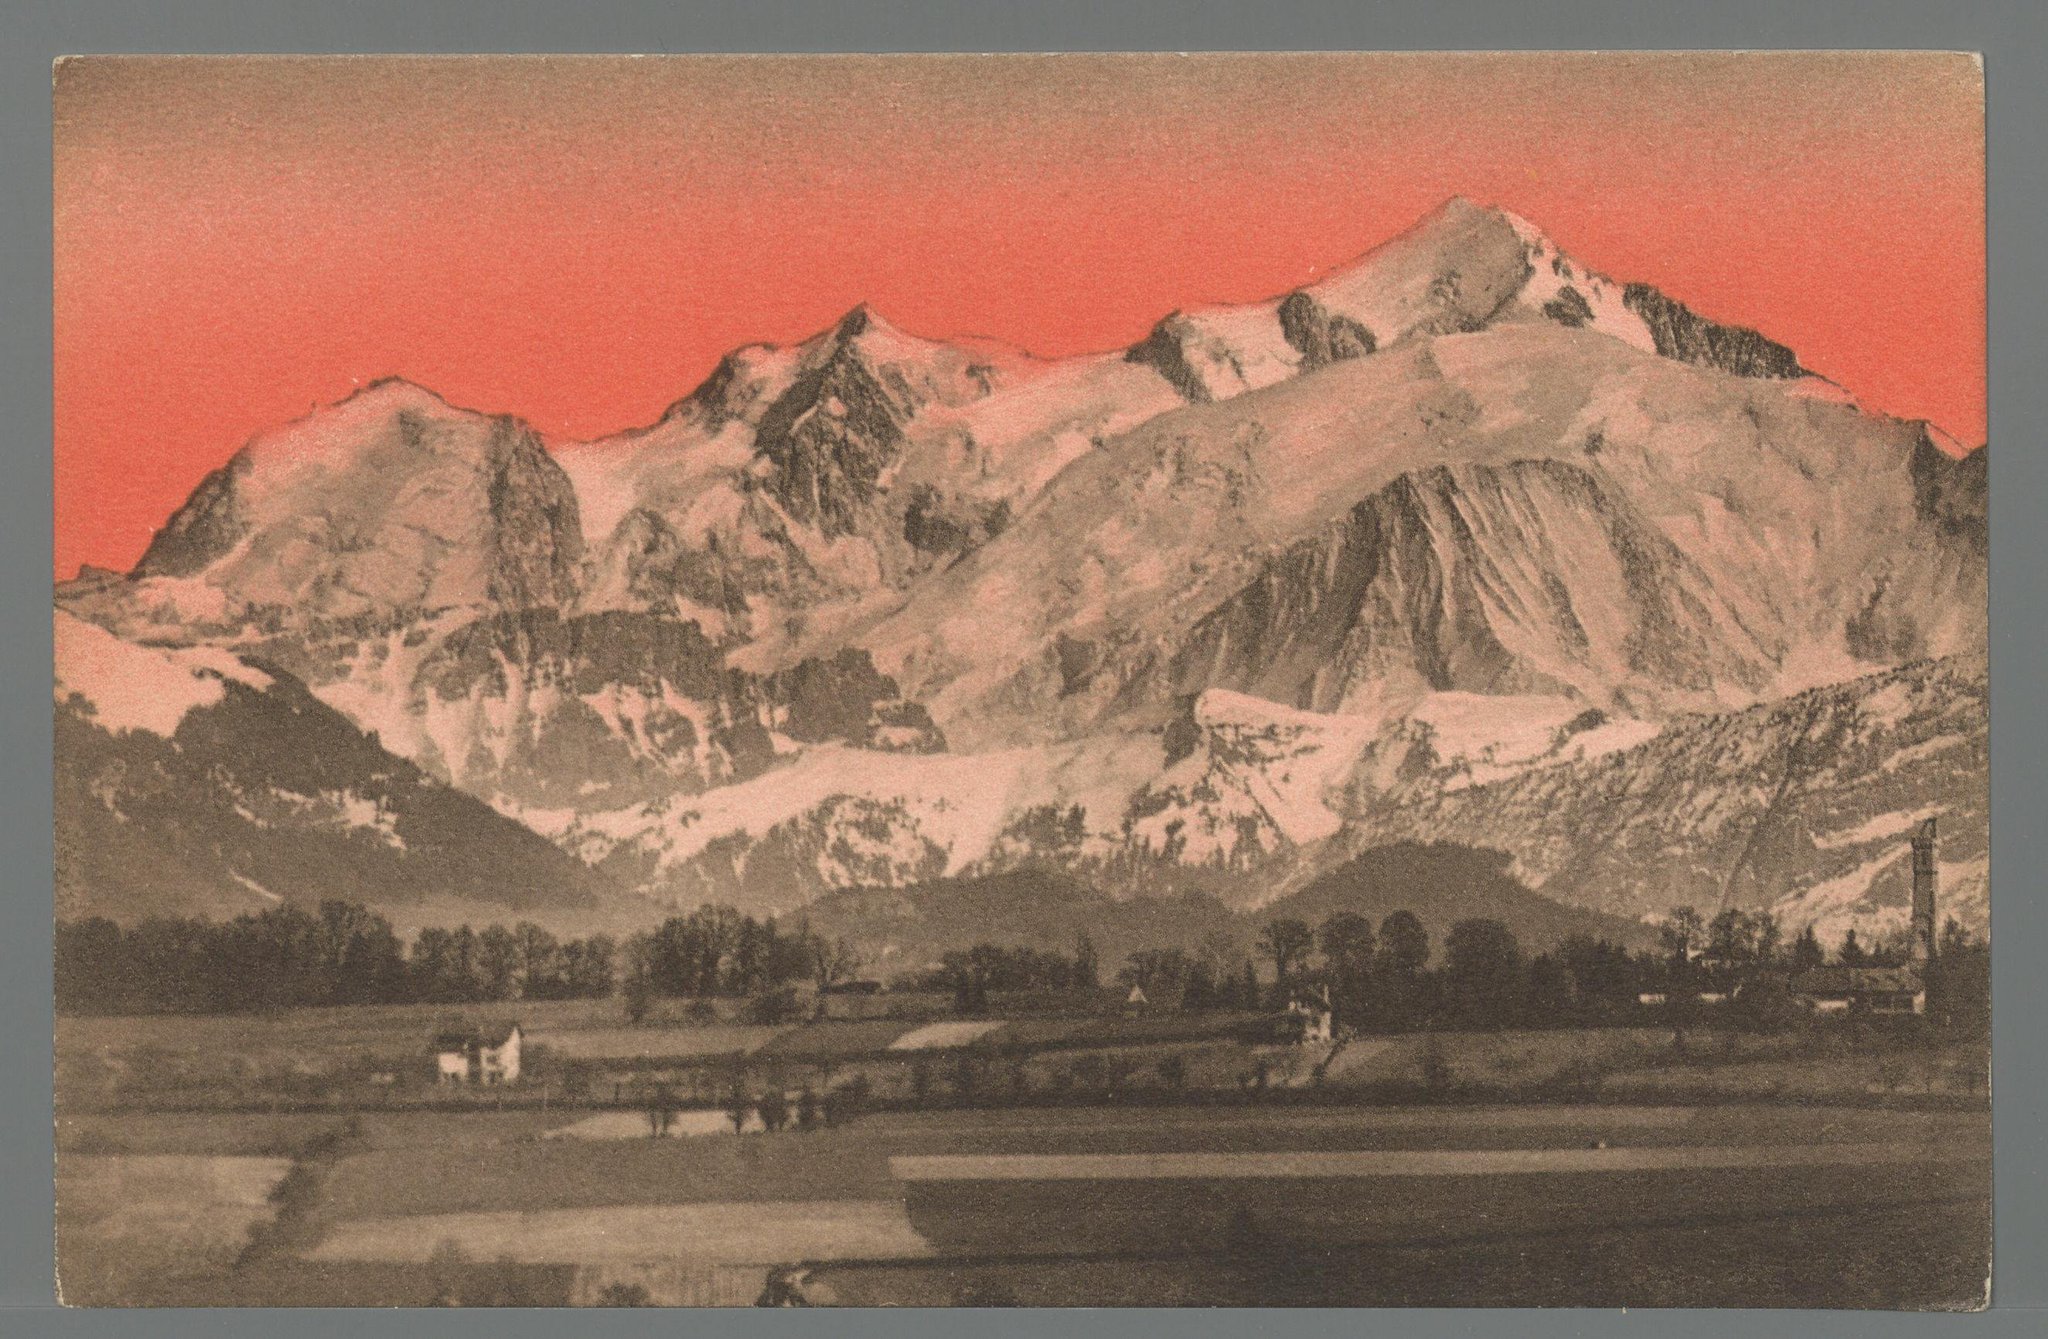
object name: photomechanical print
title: Massif du Mont-Blanc (alt. 4810 m)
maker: Anonymous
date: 1905-1909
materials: cardboard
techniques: photograph, lithograph, writing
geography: alps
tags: dale, valley, mountain-range, snow peaks